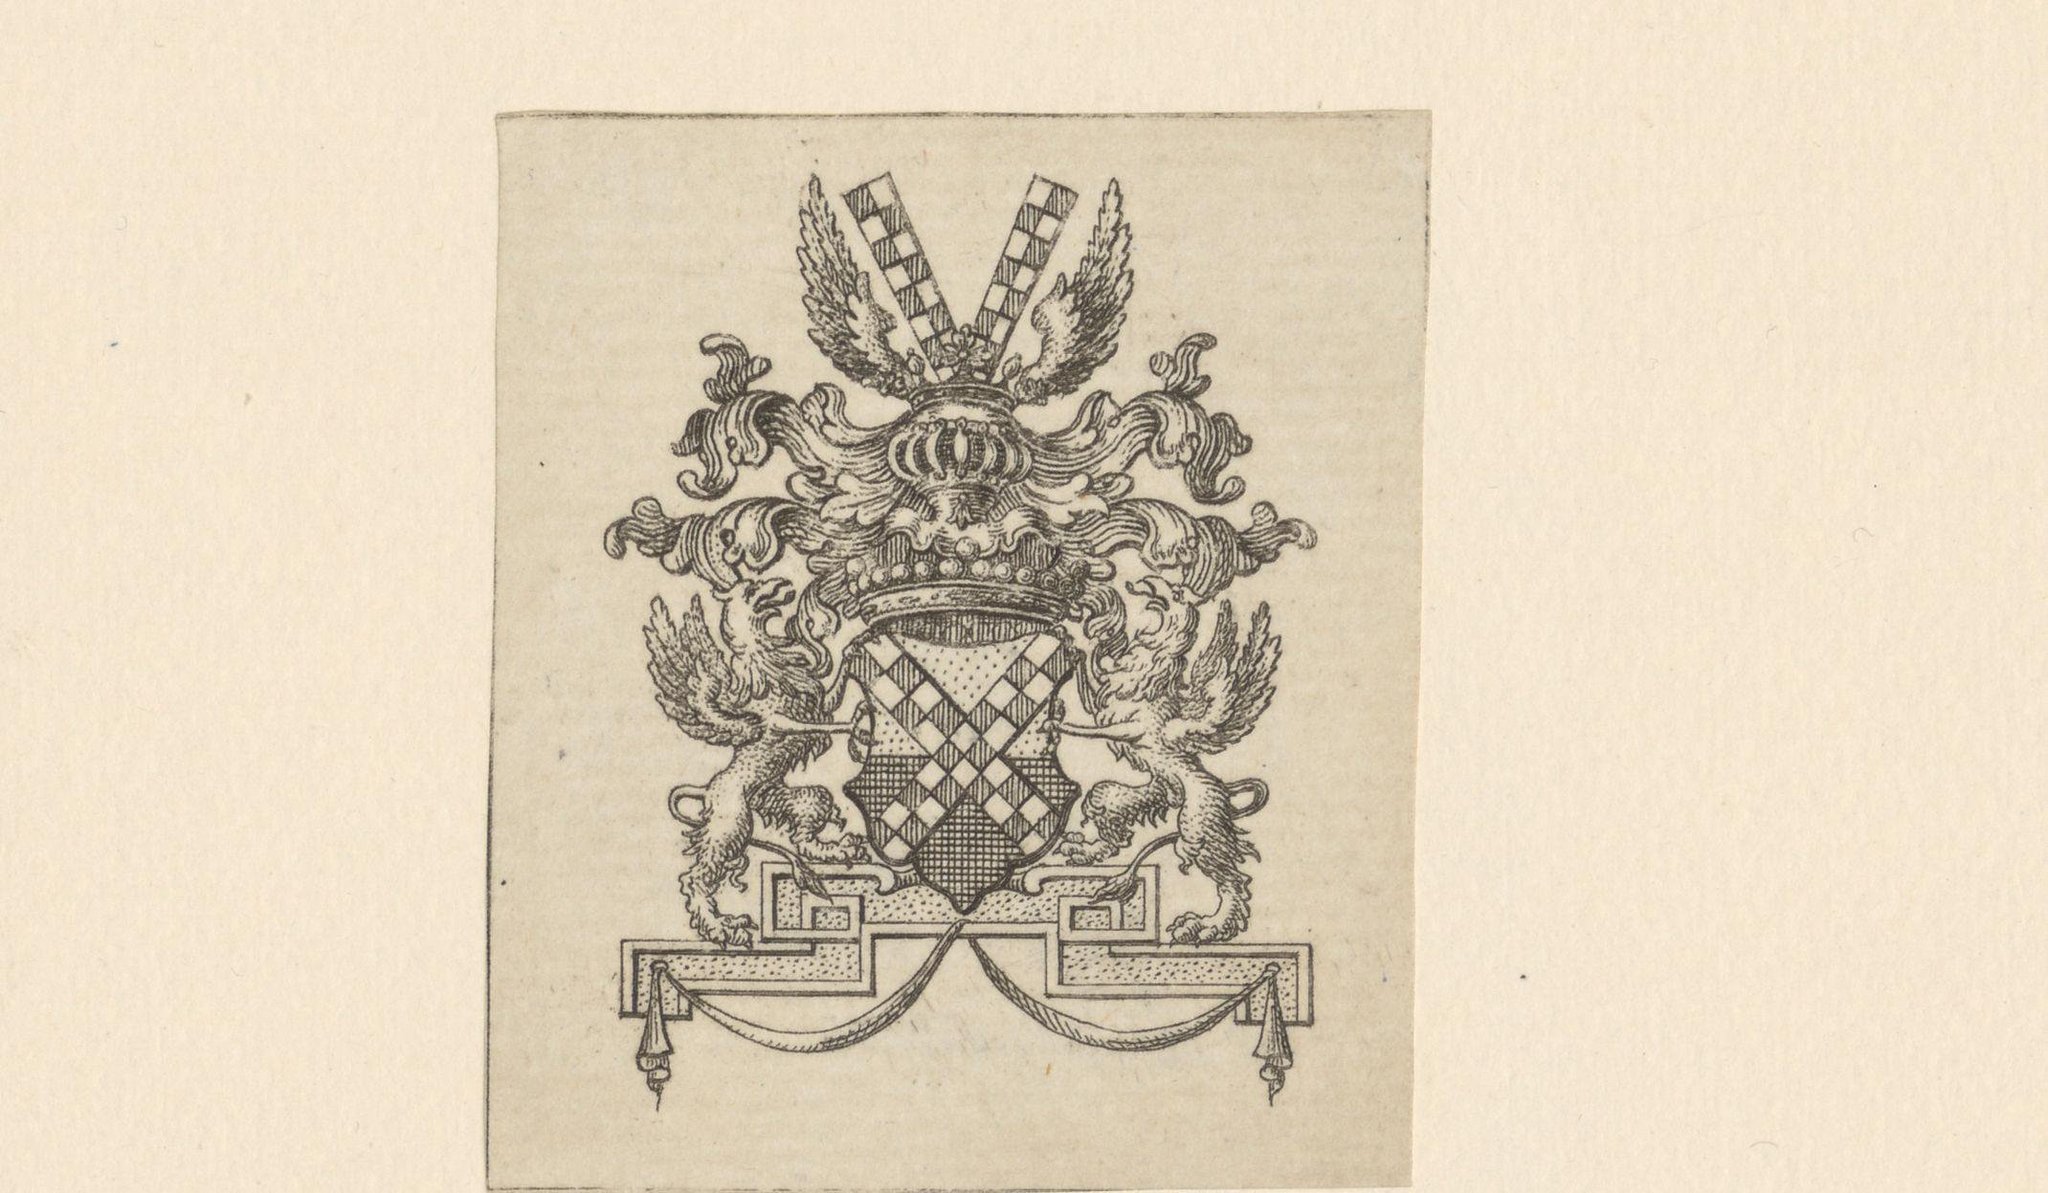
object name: bookplate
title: Ex libris van Van der Dussen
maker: Anonymous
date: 1700-1799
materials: paper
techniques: etching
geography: netherlands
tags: griffin (lion/eagle); 'griffo' (ripa), armorial bearing, heraldry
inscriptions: inscription: ‘van der Dussen / Brab. Sept (?)’, collector's mark: Lugt 2760, collector's mark: Lugt 2233